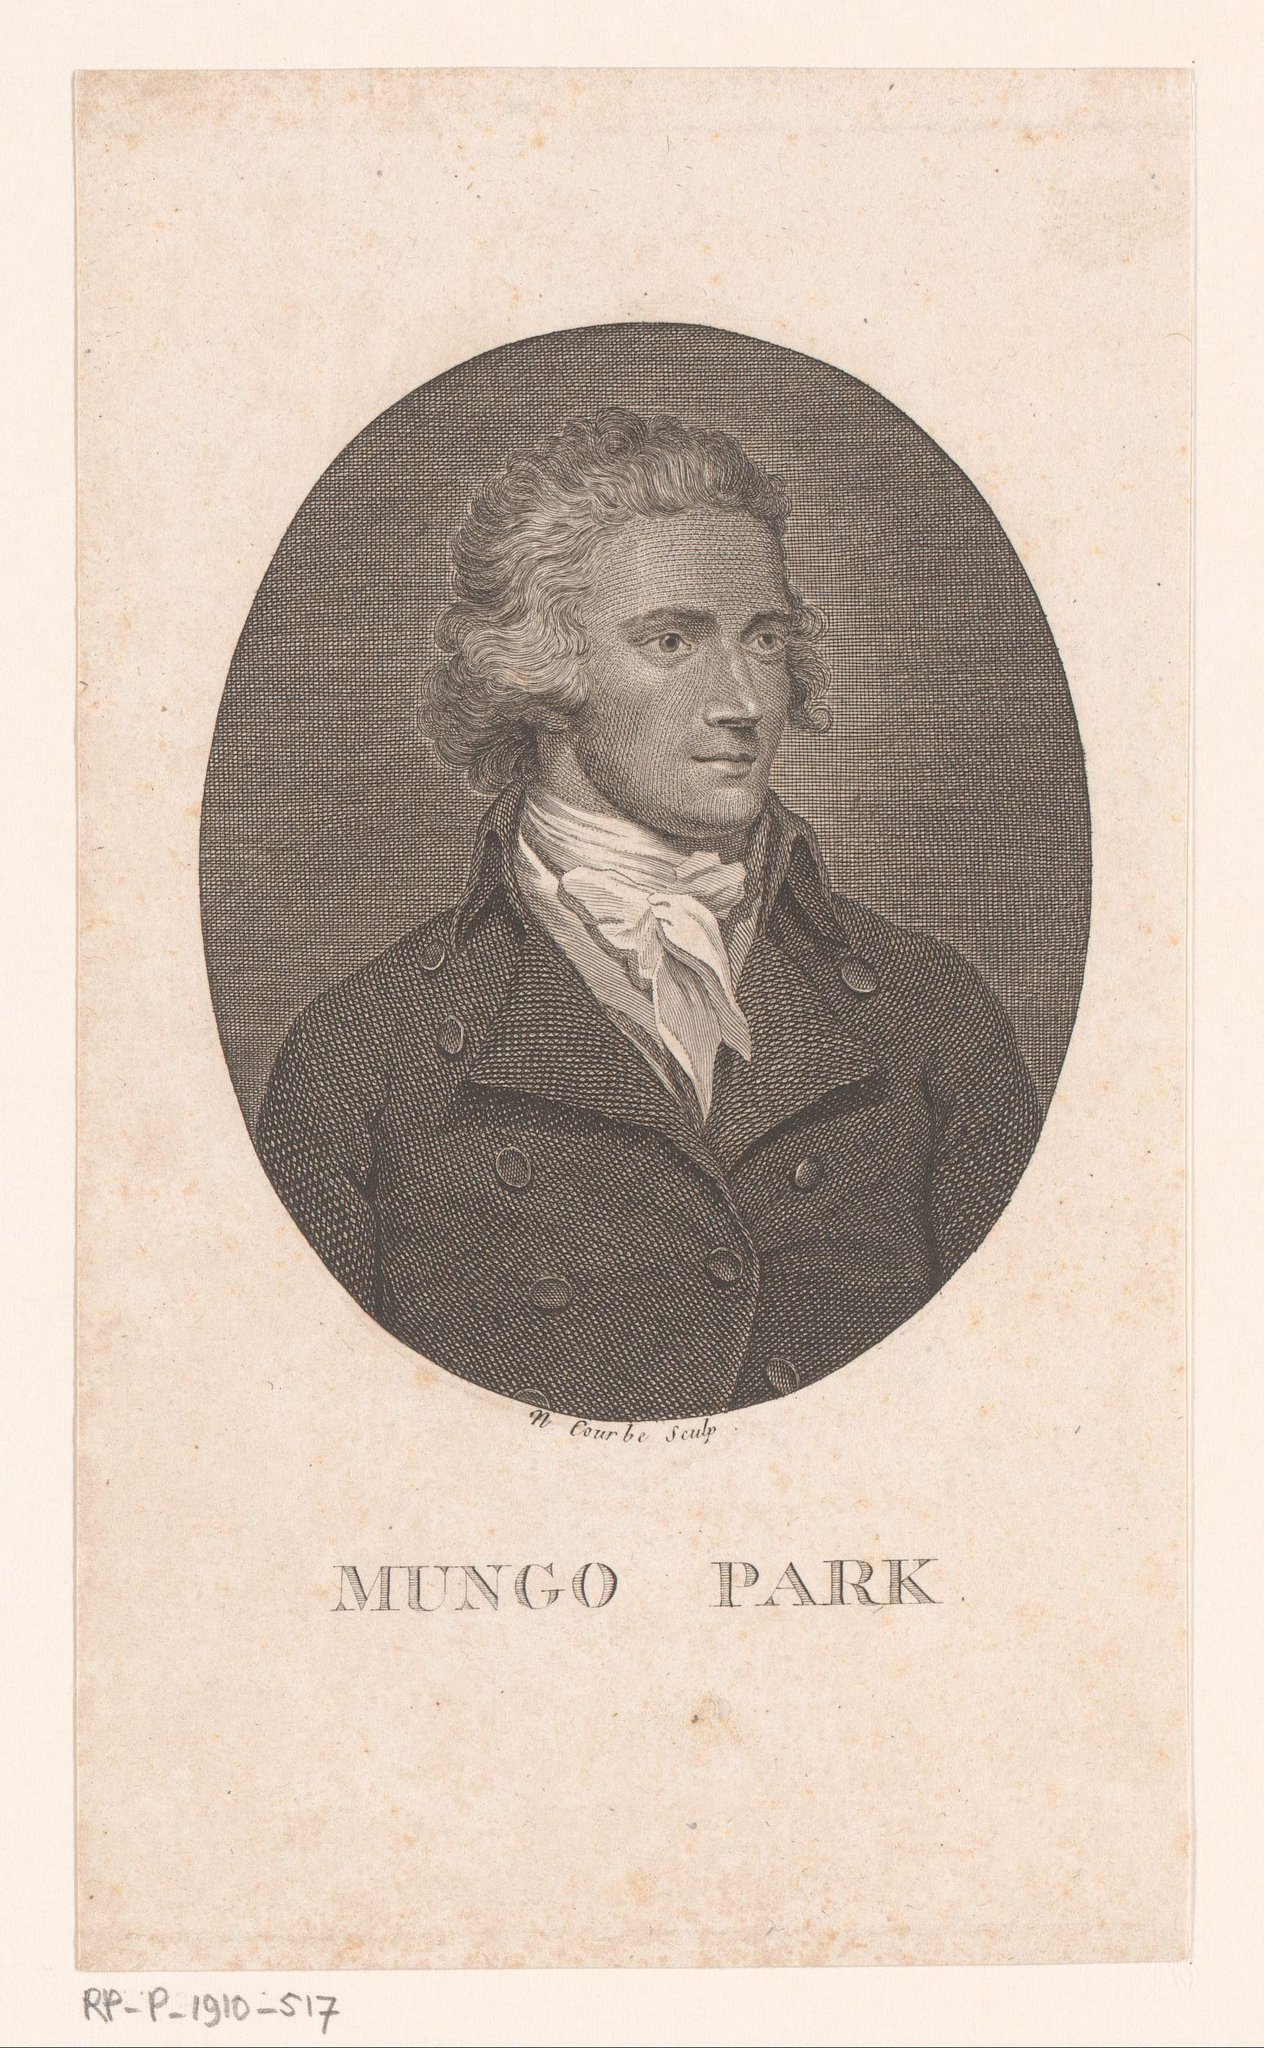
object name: print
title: Portret van Mungo Park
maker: wilbrod magloire nicolas courbe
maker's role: print maker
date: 1792-1807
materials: paper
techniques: engraving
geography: france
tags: historical persons, explorer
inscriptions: collector's mark: Lugt 2228